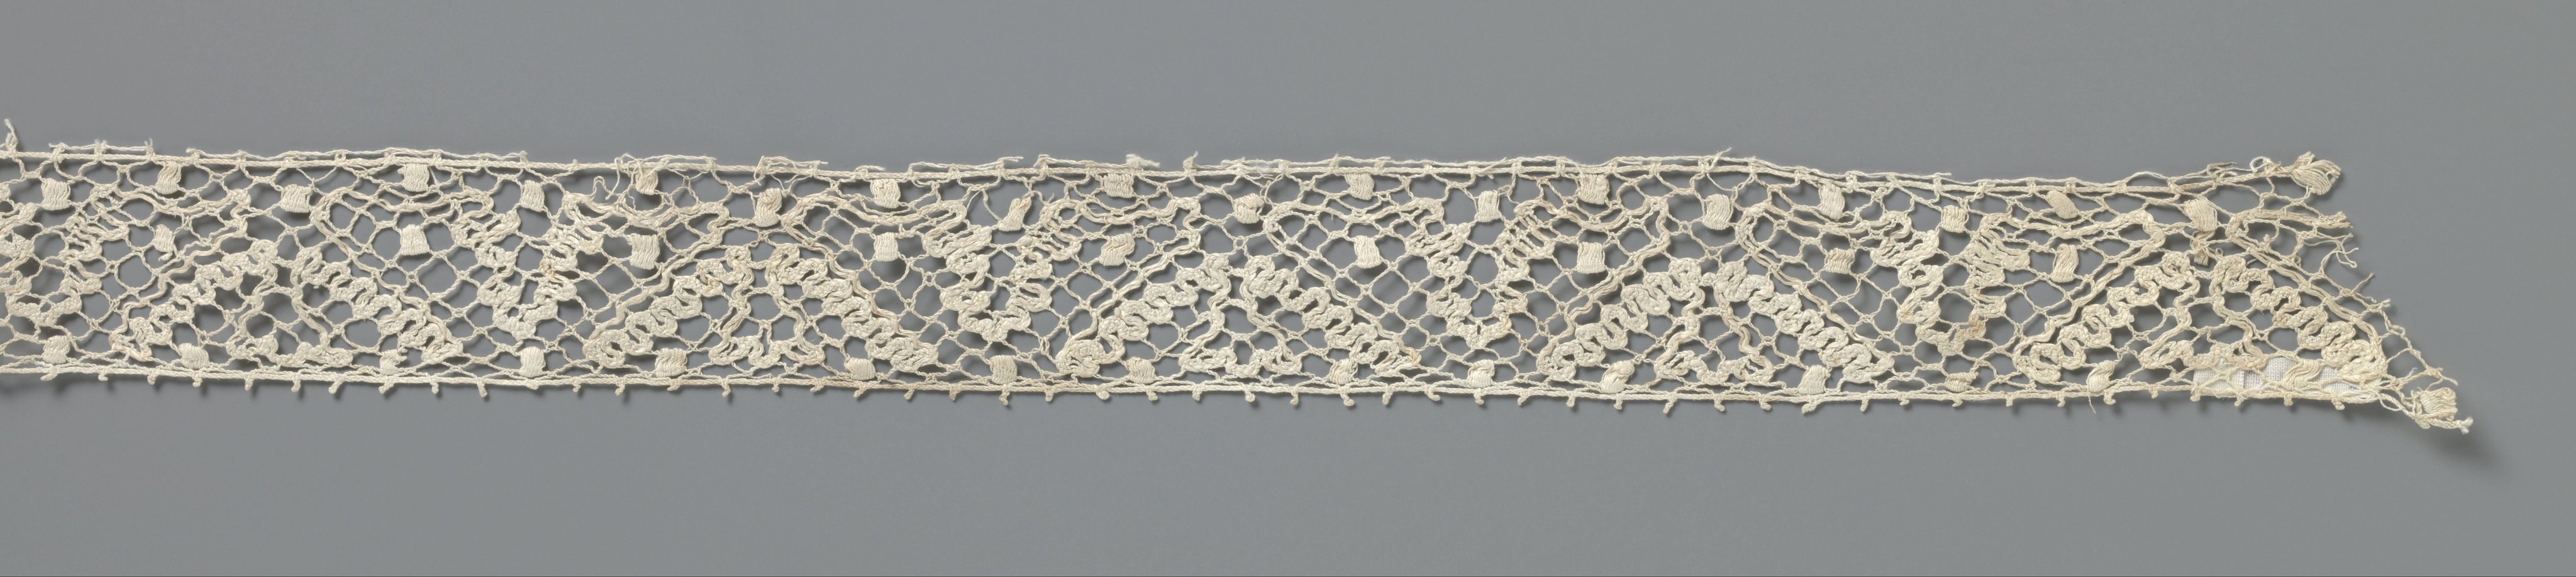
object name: strip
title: Strook kloskant met driehoekige velden en gestileerde kelkbloem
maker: Anonymous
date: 1600-1879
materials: linen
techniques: lace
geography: karlberg palace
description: Strook naturelkleurige kloskant. Het zich herhalende patroon bestaat uit twee afwisselende driehoekige velden. Het ene veld wordt gevormd door een recht naar beneden hangende, gestileerde kelkbloem tussen twee bladeren. Het andere driehoekige veld wordt gevormd door de ruimte tussen twee opeenvolgende velden met kelkbloemen in. In dit veld staat een min of meer kerstboomvormig motief. De motieven zijn met elkaar verbonden door een grove ruitvormige maasgrond, een vetergatslag-traliegrond, bezaaid met vierkante moesjes. De motieven zijn gemaakt met dikke contourdraden en regelmatig kronkelende gevlochten bandjes. De moesjes zijn gemaakt in vormslag. Boven- en onderzijde van de strook zijn recht afgewerkt, waarbij de onderzijde is voorzien van picots.